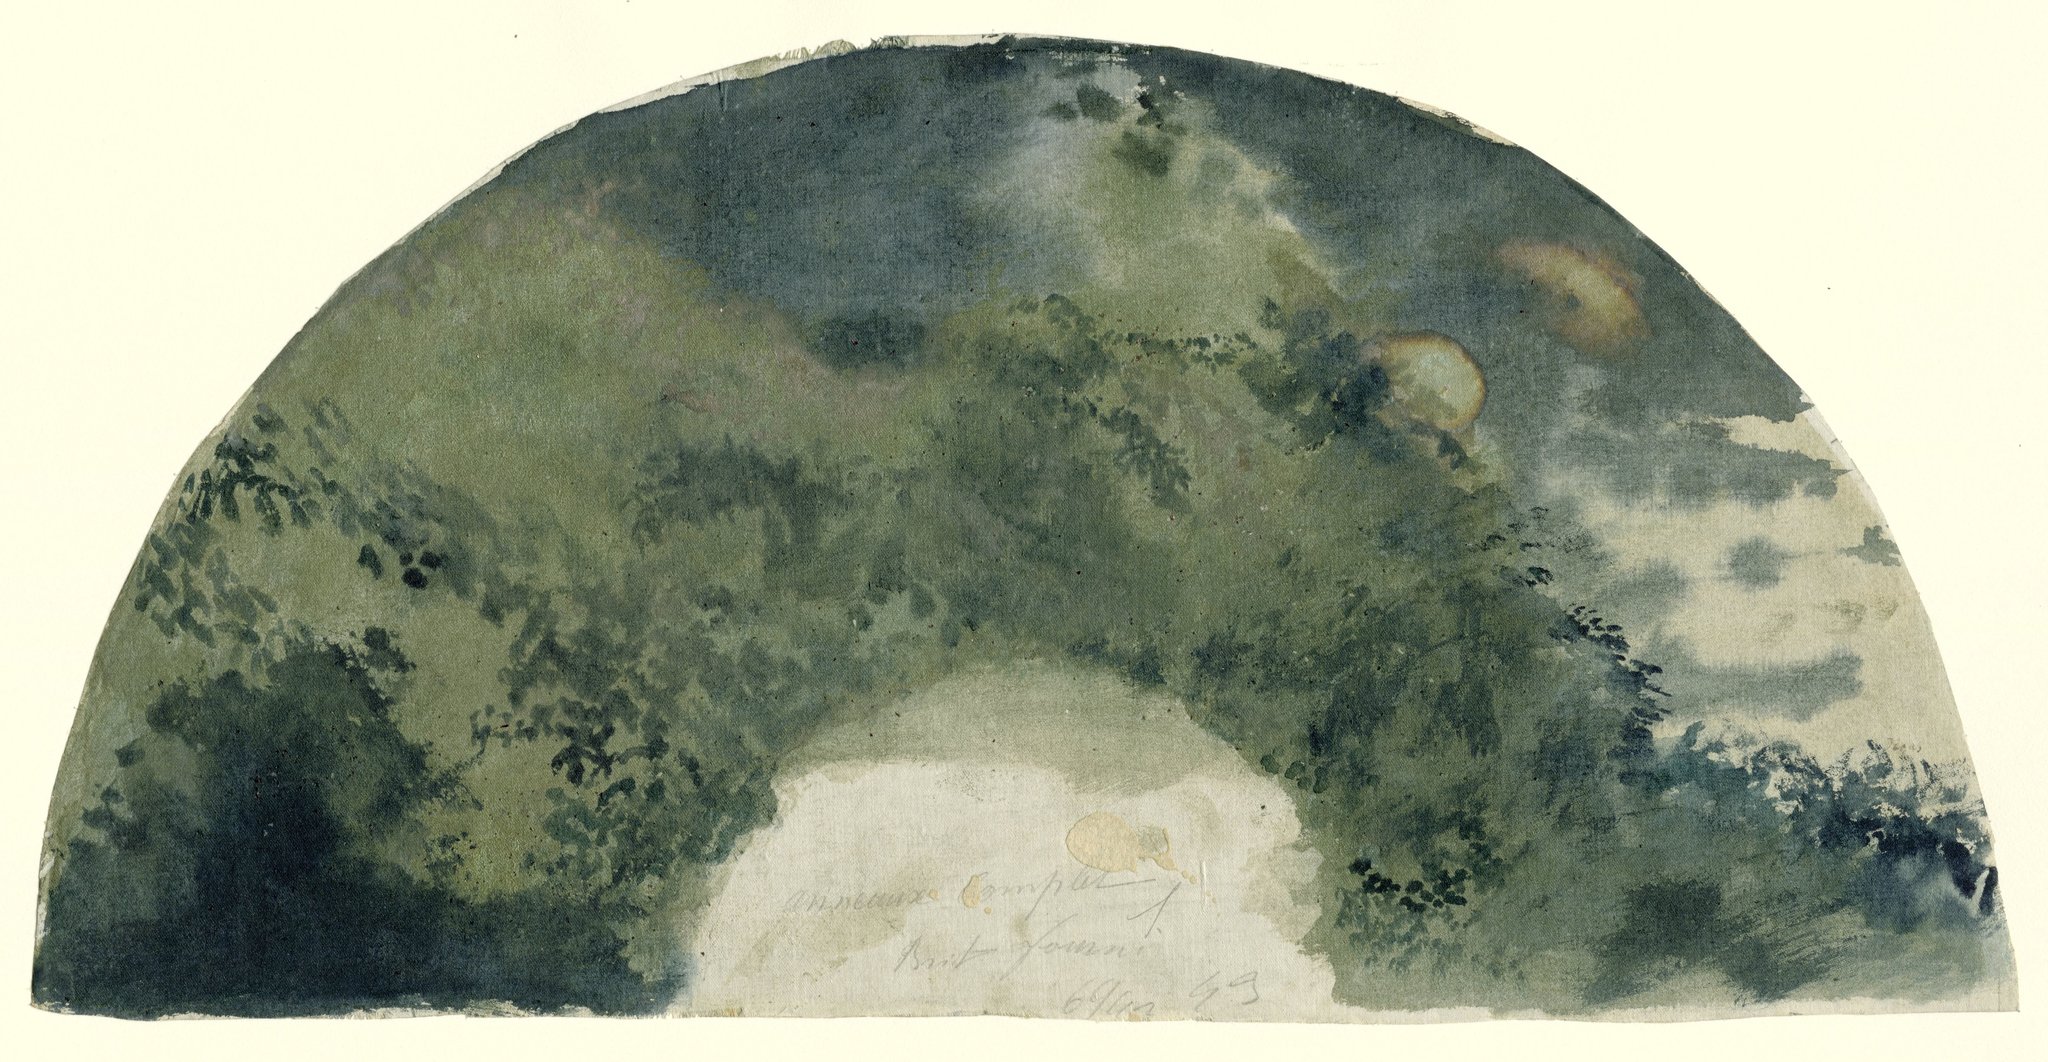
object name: drawing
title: Waaierblad in Japanse trant beschilderd met een landschap bij opkomende maan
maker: edgar degas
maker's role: draughtsman, painter, print maker, sculptor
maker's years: 1834-1917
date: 1850-1900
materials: gold powder, silk, watercolor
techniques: brush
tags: moonrise, fan, forest, wood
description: Schildering op zijde bedoeld als ontwerp voor een waaierblad, een landschap met bergen bij een opkomende maan.